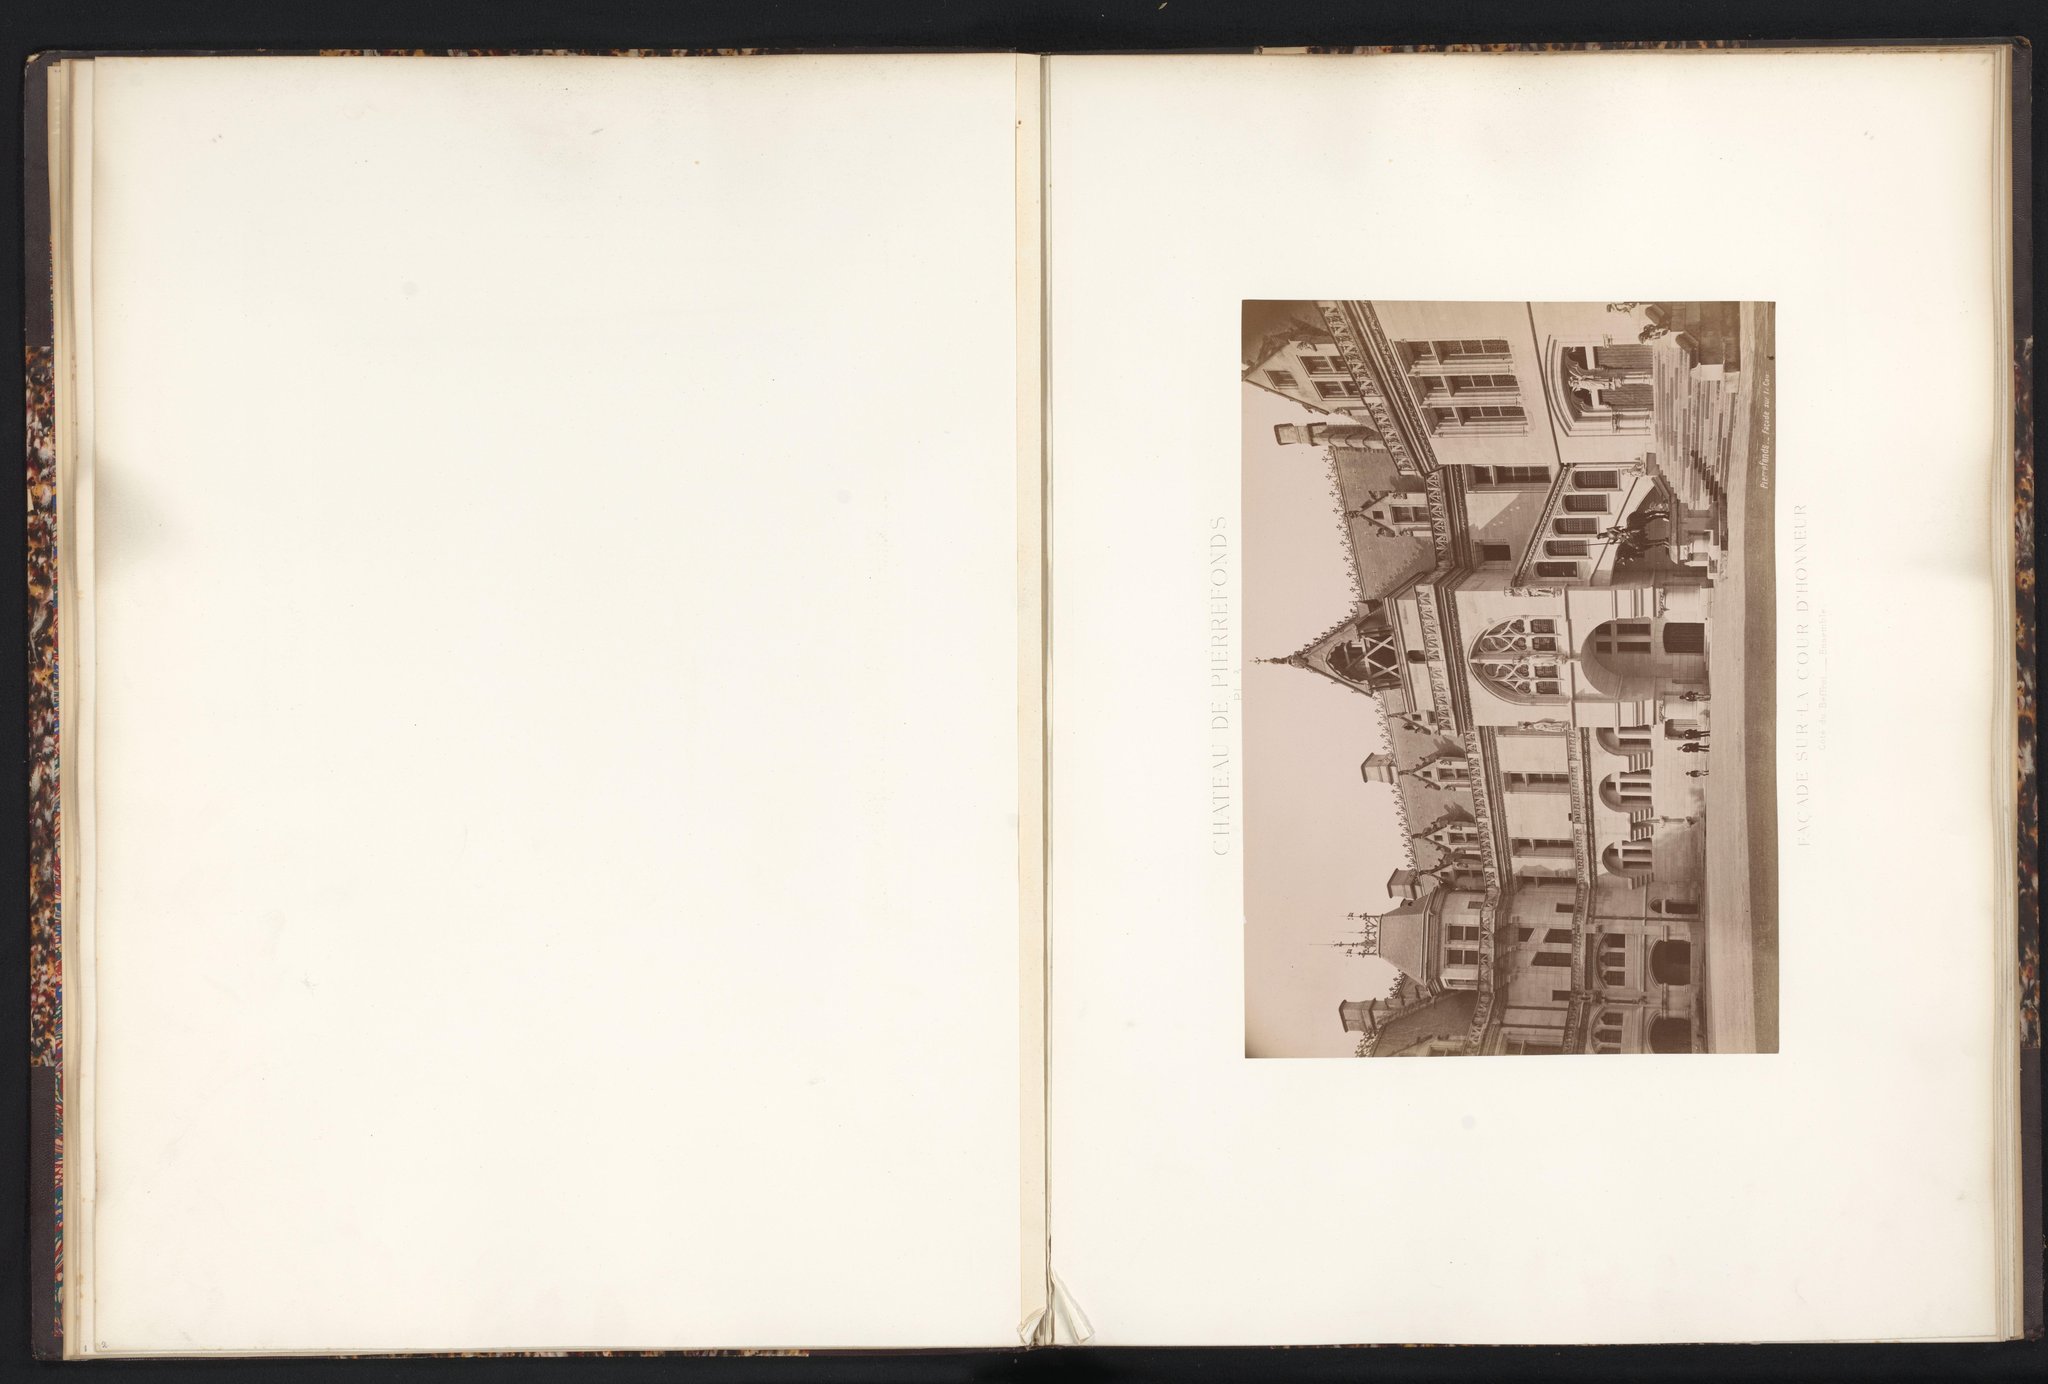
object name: photograph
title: Gezicht op de klokkentoren aan de binnenplaats van het kasteel van Pierrefonds, Frankrijk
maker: séraphin-médéric mieusement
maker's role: fotograaf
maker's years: 1840-1905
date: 1870-1875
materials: photographic support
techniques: albumen print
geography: pierrefonds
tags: tower, clock tower ~ monumental adornment, castle, courtyard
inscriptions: inscription: ‘PIERREFONDS - Façade sur la Cour’, number: ‘PL. 3’